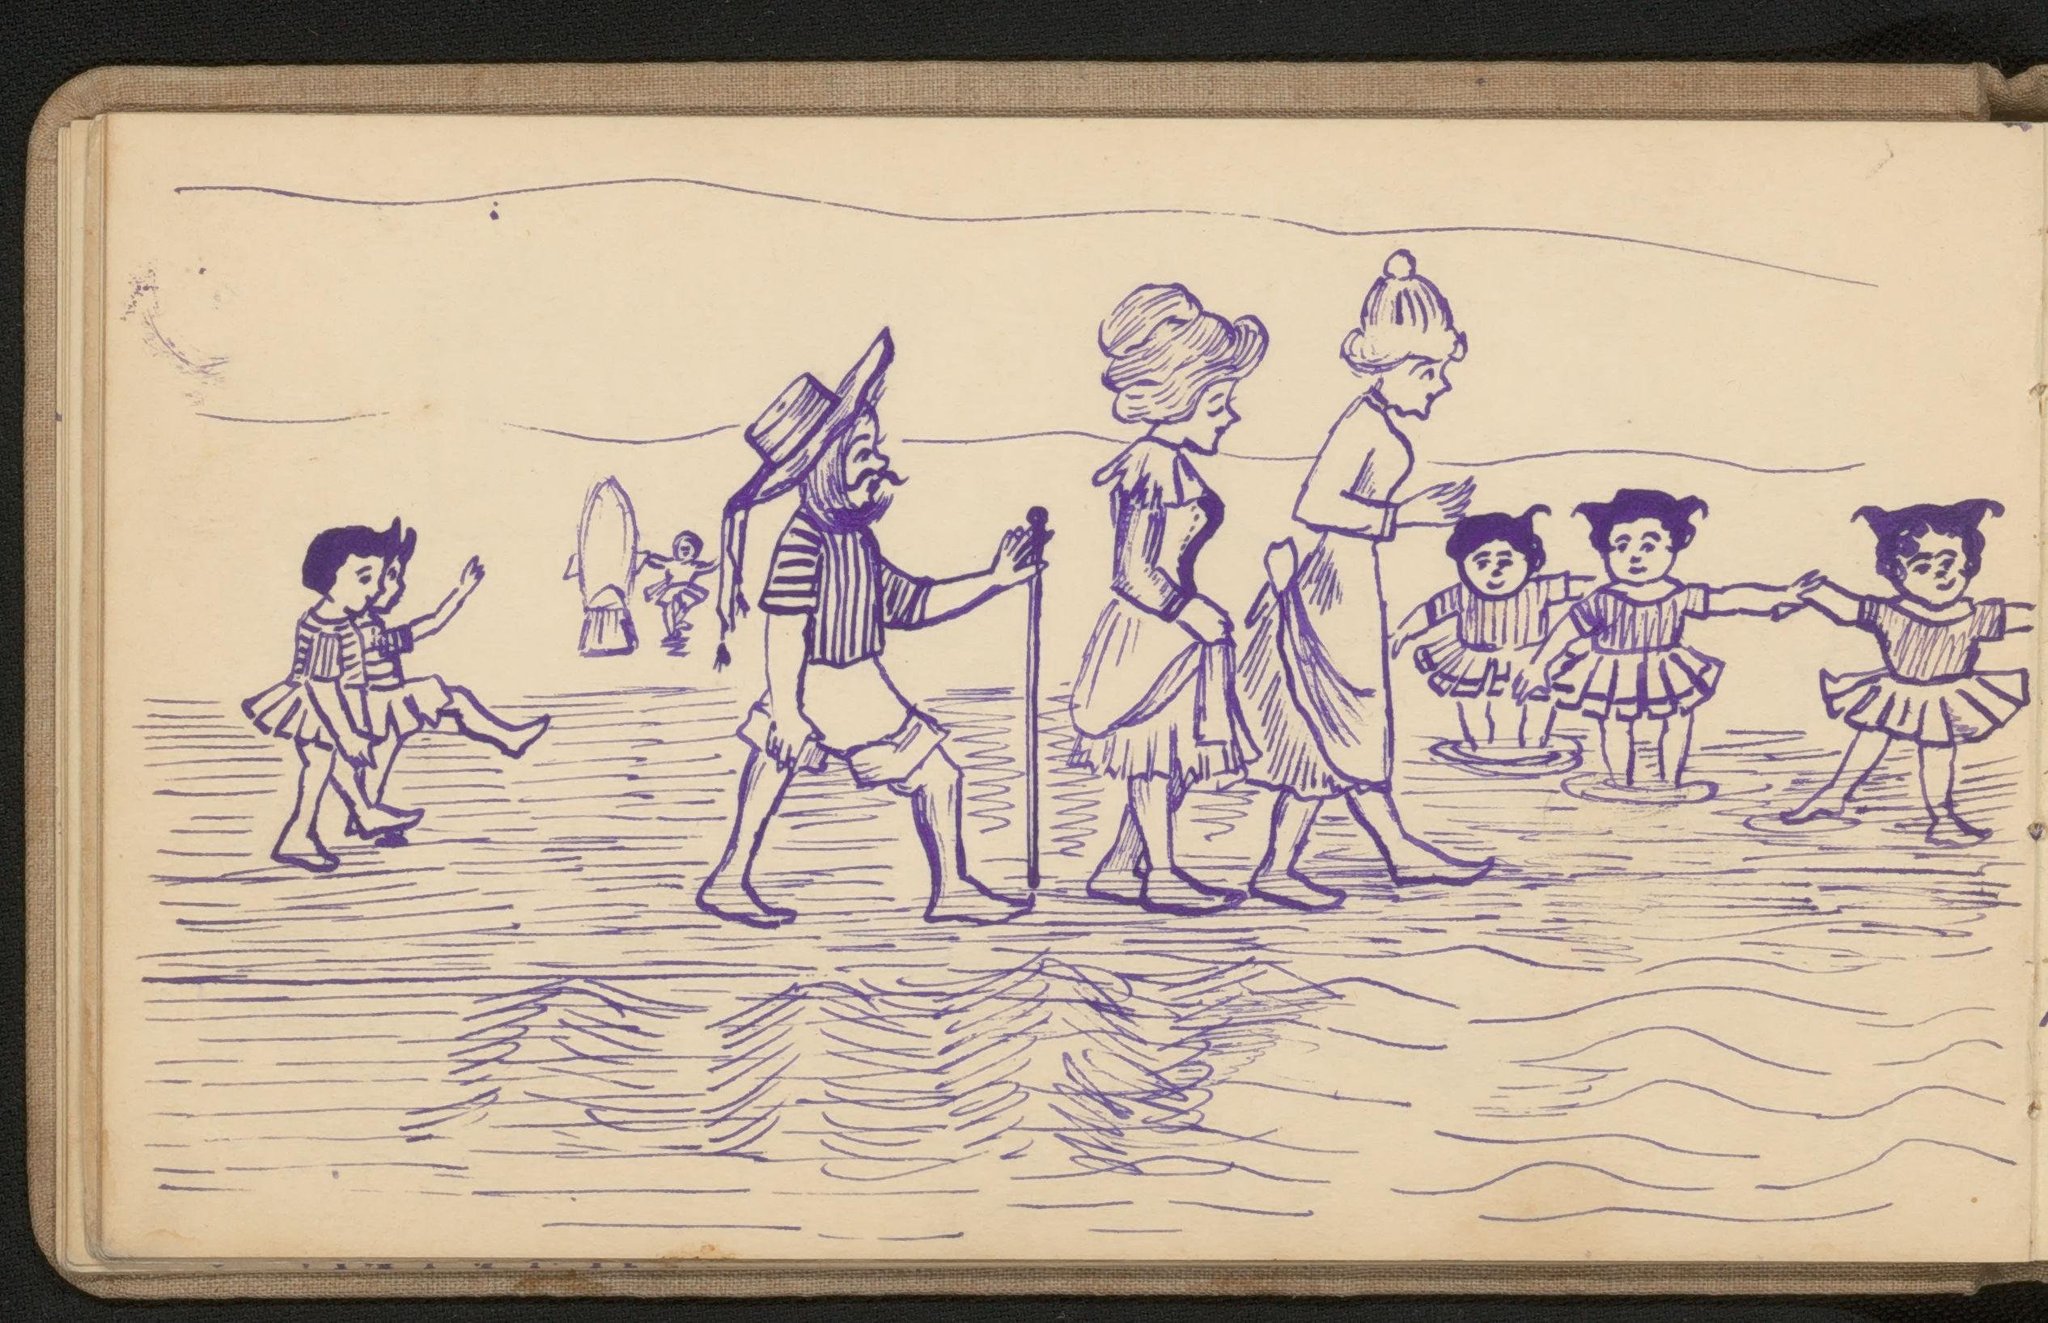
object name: sketchbook leaf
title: Strandwandeling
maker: Anonymous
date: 1875-1920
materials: ink, paper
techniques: pen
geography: netherlands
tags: beach (as place of recreation), the family travelling, on holiday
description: Het gezin op het strand. Onderdeel van het schetsboek met humoristische tekeningen over het leven van een 'famille nombreuse'. Onderwerpsrubrieken binnen de Atlas Zeden en Gewoonten: Zeden en Gewoonten in Engeren Zin, Des menschen beging, midden en einde, Kinderleven.